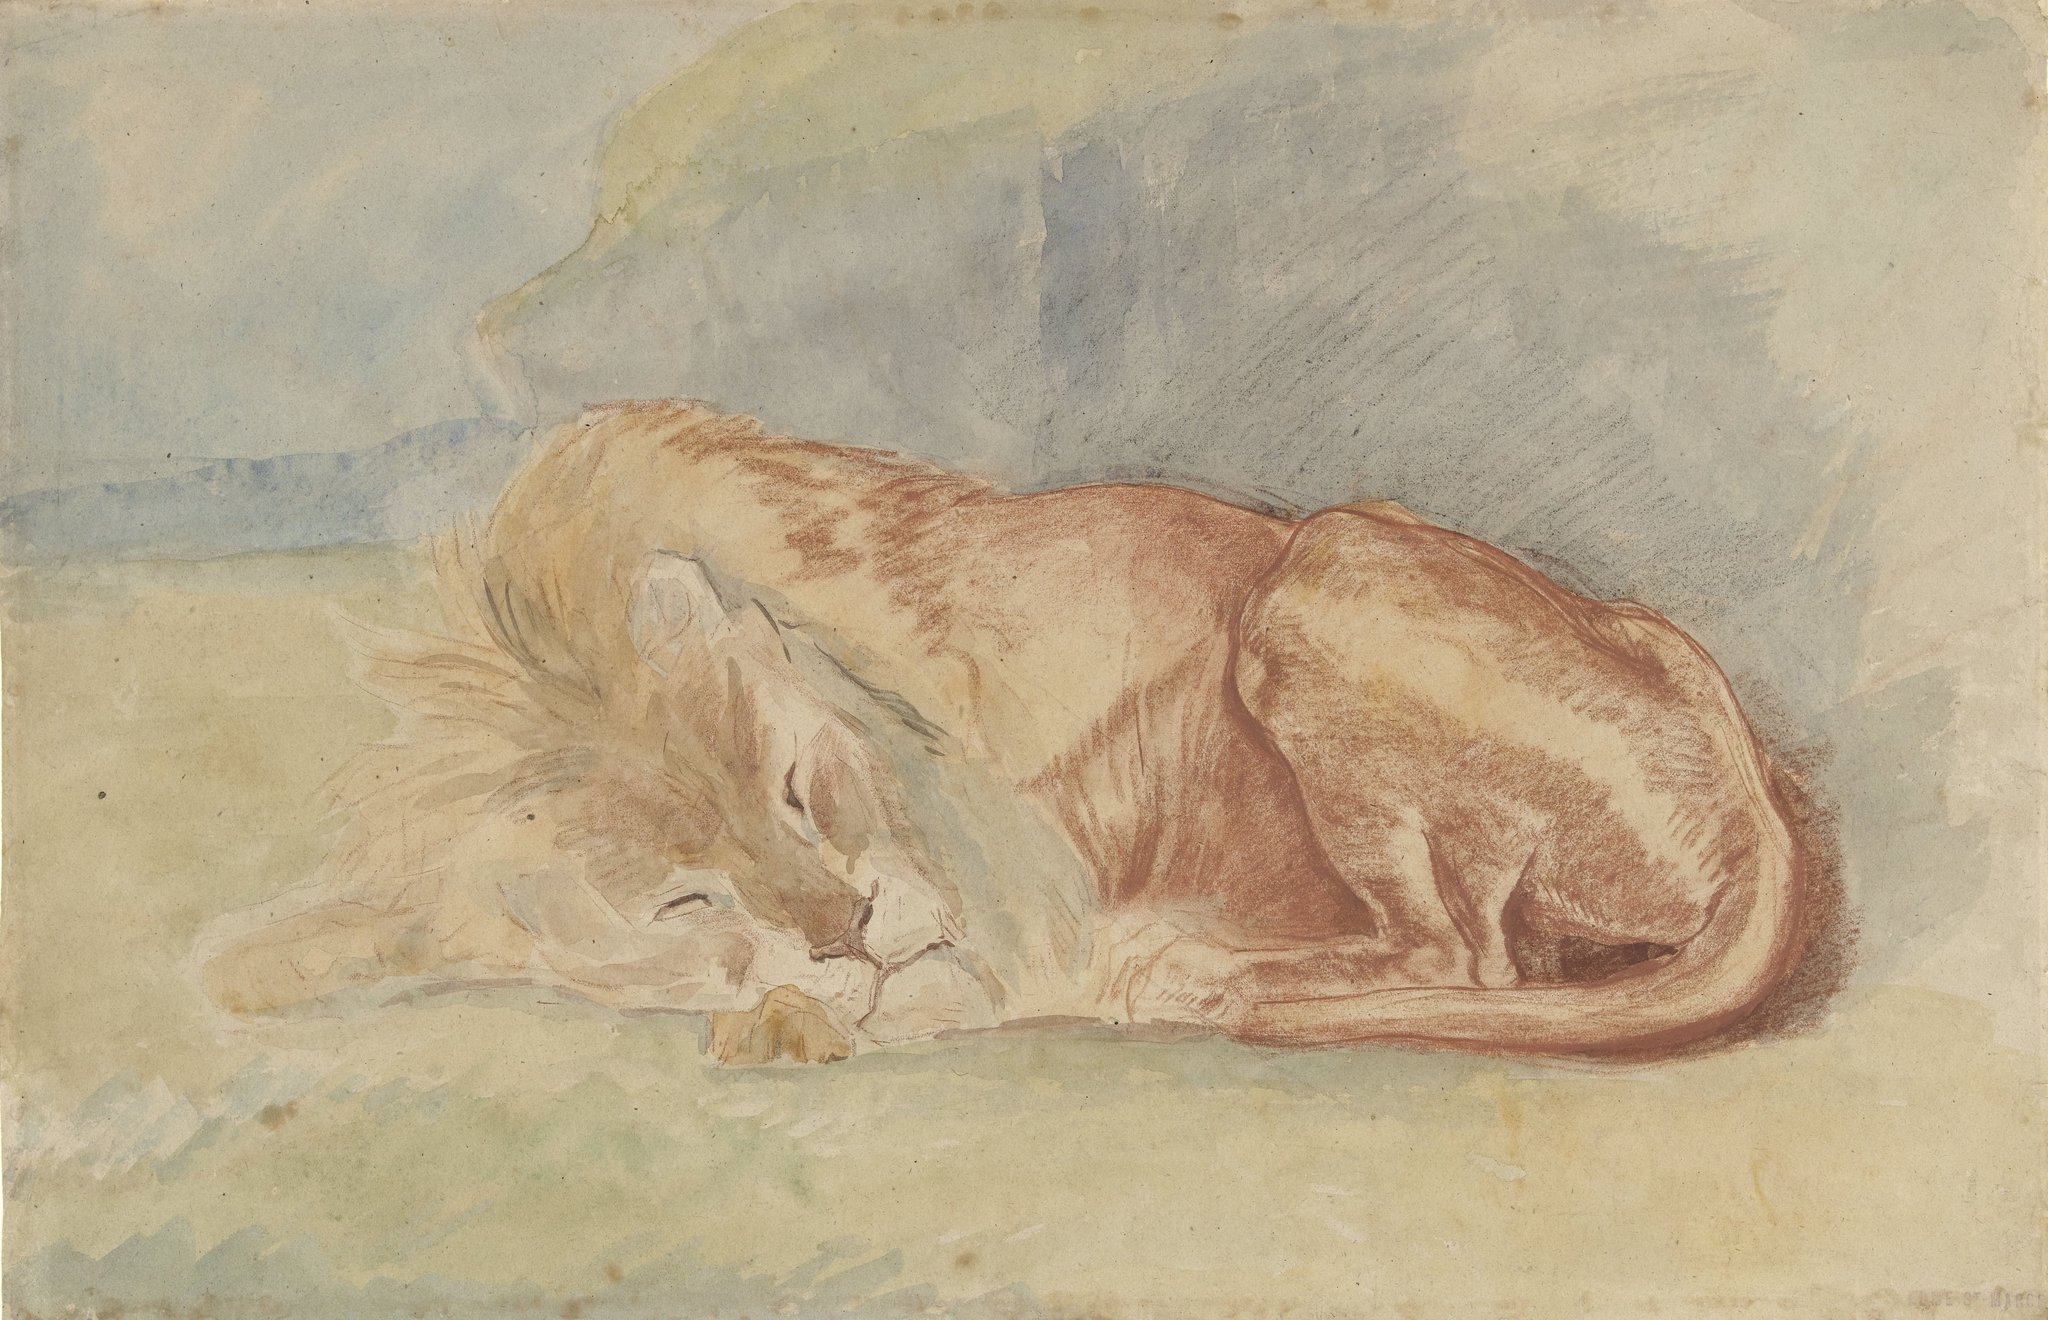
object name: drawing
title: Slapende leeuw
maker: charles edmé saint-marcel-cabin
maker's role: draughtsman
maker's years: 1819-1890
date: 1829-1890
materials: chalk, paper, watercolor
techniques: brush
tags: sleeping; unconsciousness